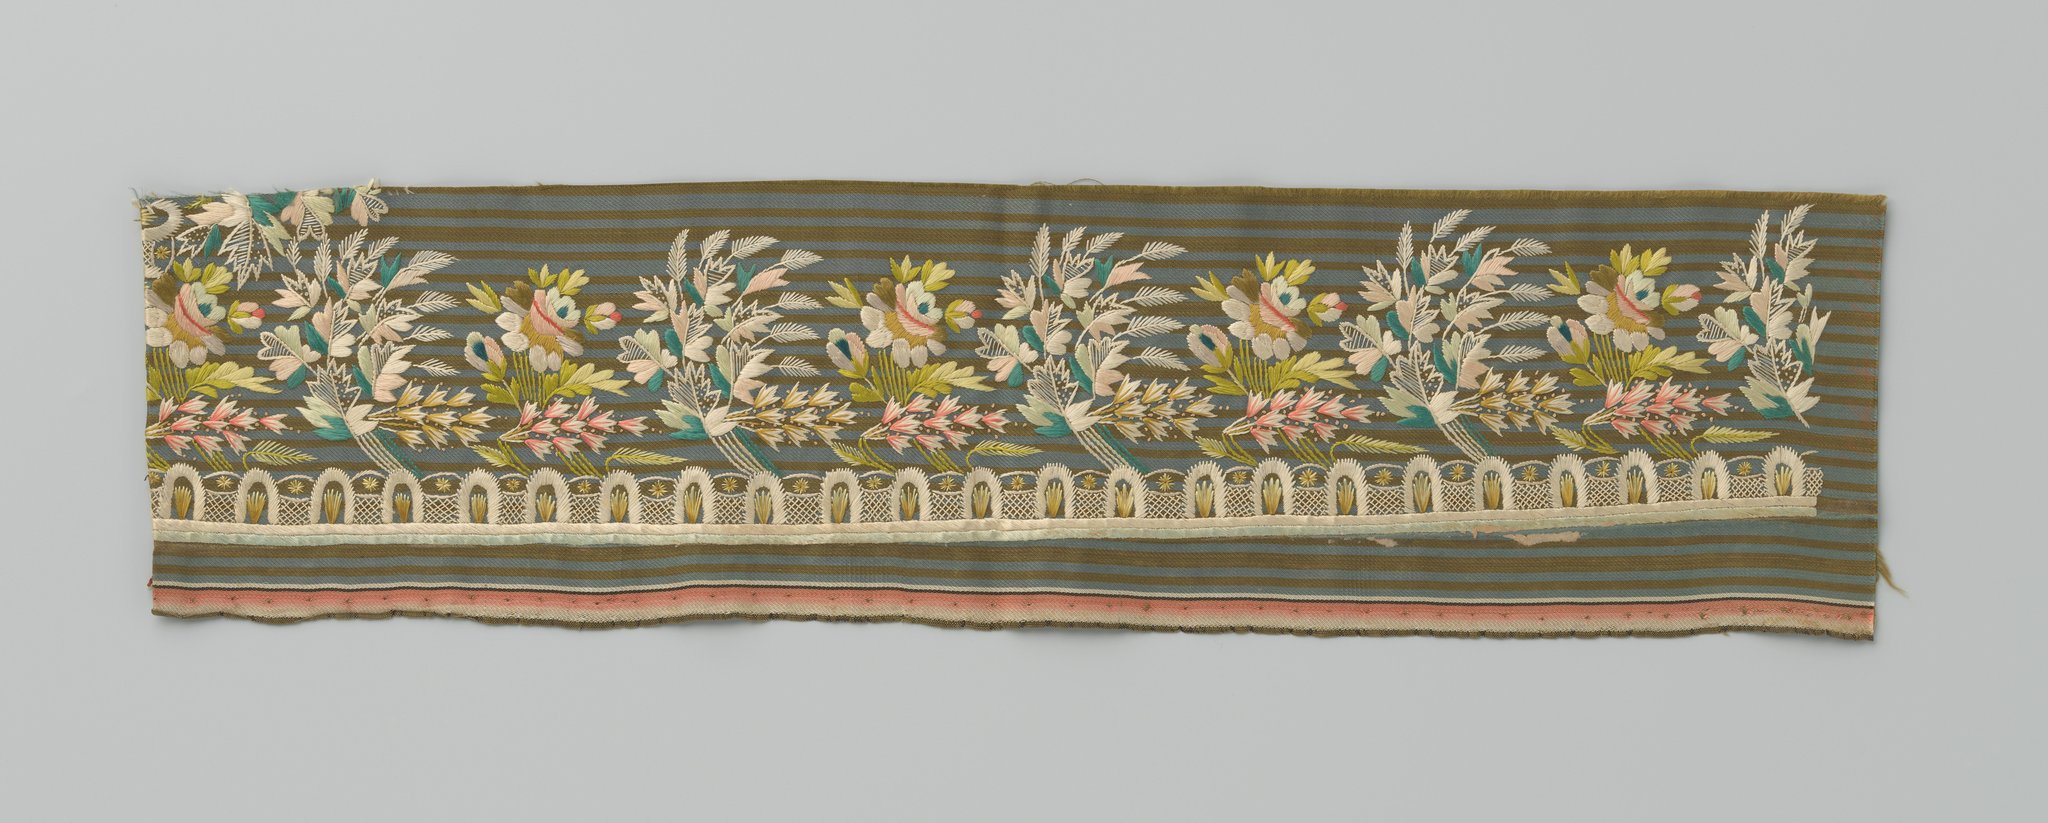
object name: woven material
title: Fragment met borduurwerk met bloemen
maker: Anonymous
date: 1800-1930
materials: textile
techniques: embroidered, weave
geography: europe